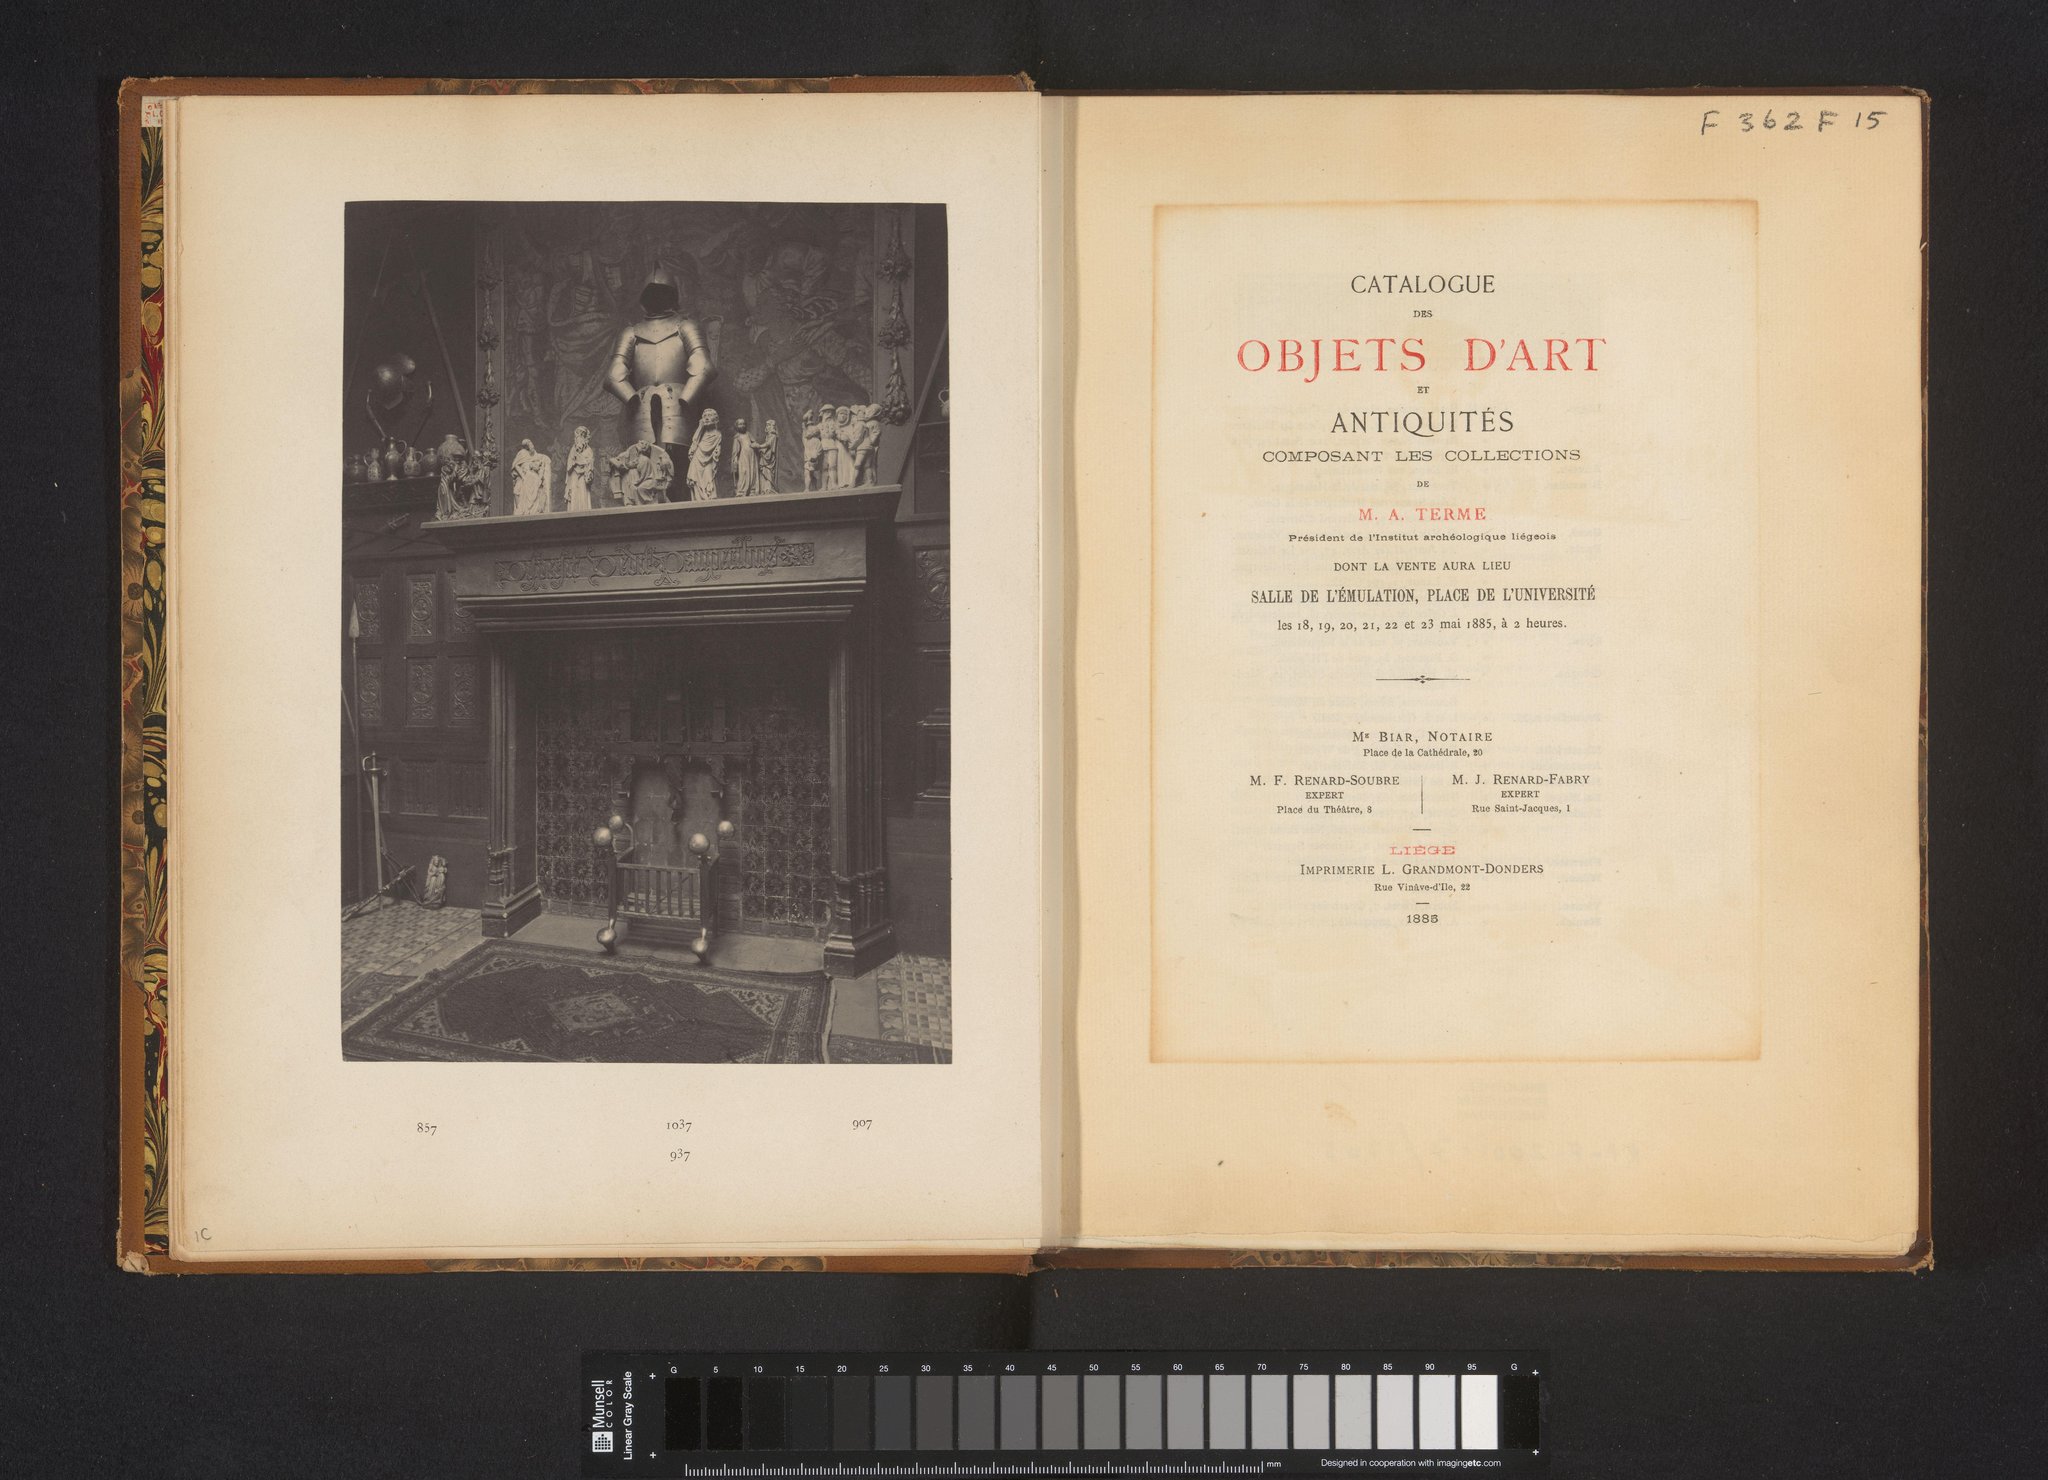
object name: book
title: Catalogue des objets d'art et antiquités composant les collections de M. A. Terme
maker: l. grandmont-donders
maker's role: publisher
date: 1885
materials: linen, paper, photographic support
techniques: albumen print, photograph, platinum process, printing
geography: liège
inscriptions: inscription: ‘Les Morts (...)’, collector's mark: ‘E B P’, collector's mark: ‘L. Claessens Relieur’, bookplate: ‘E. Brahy-Prost’, annotation: ‘22x [...] 1902’, date: ‘JAN 1990’, annotation: ‘exemplaire no 4./ J. Renard-Fabry/ Expert:’